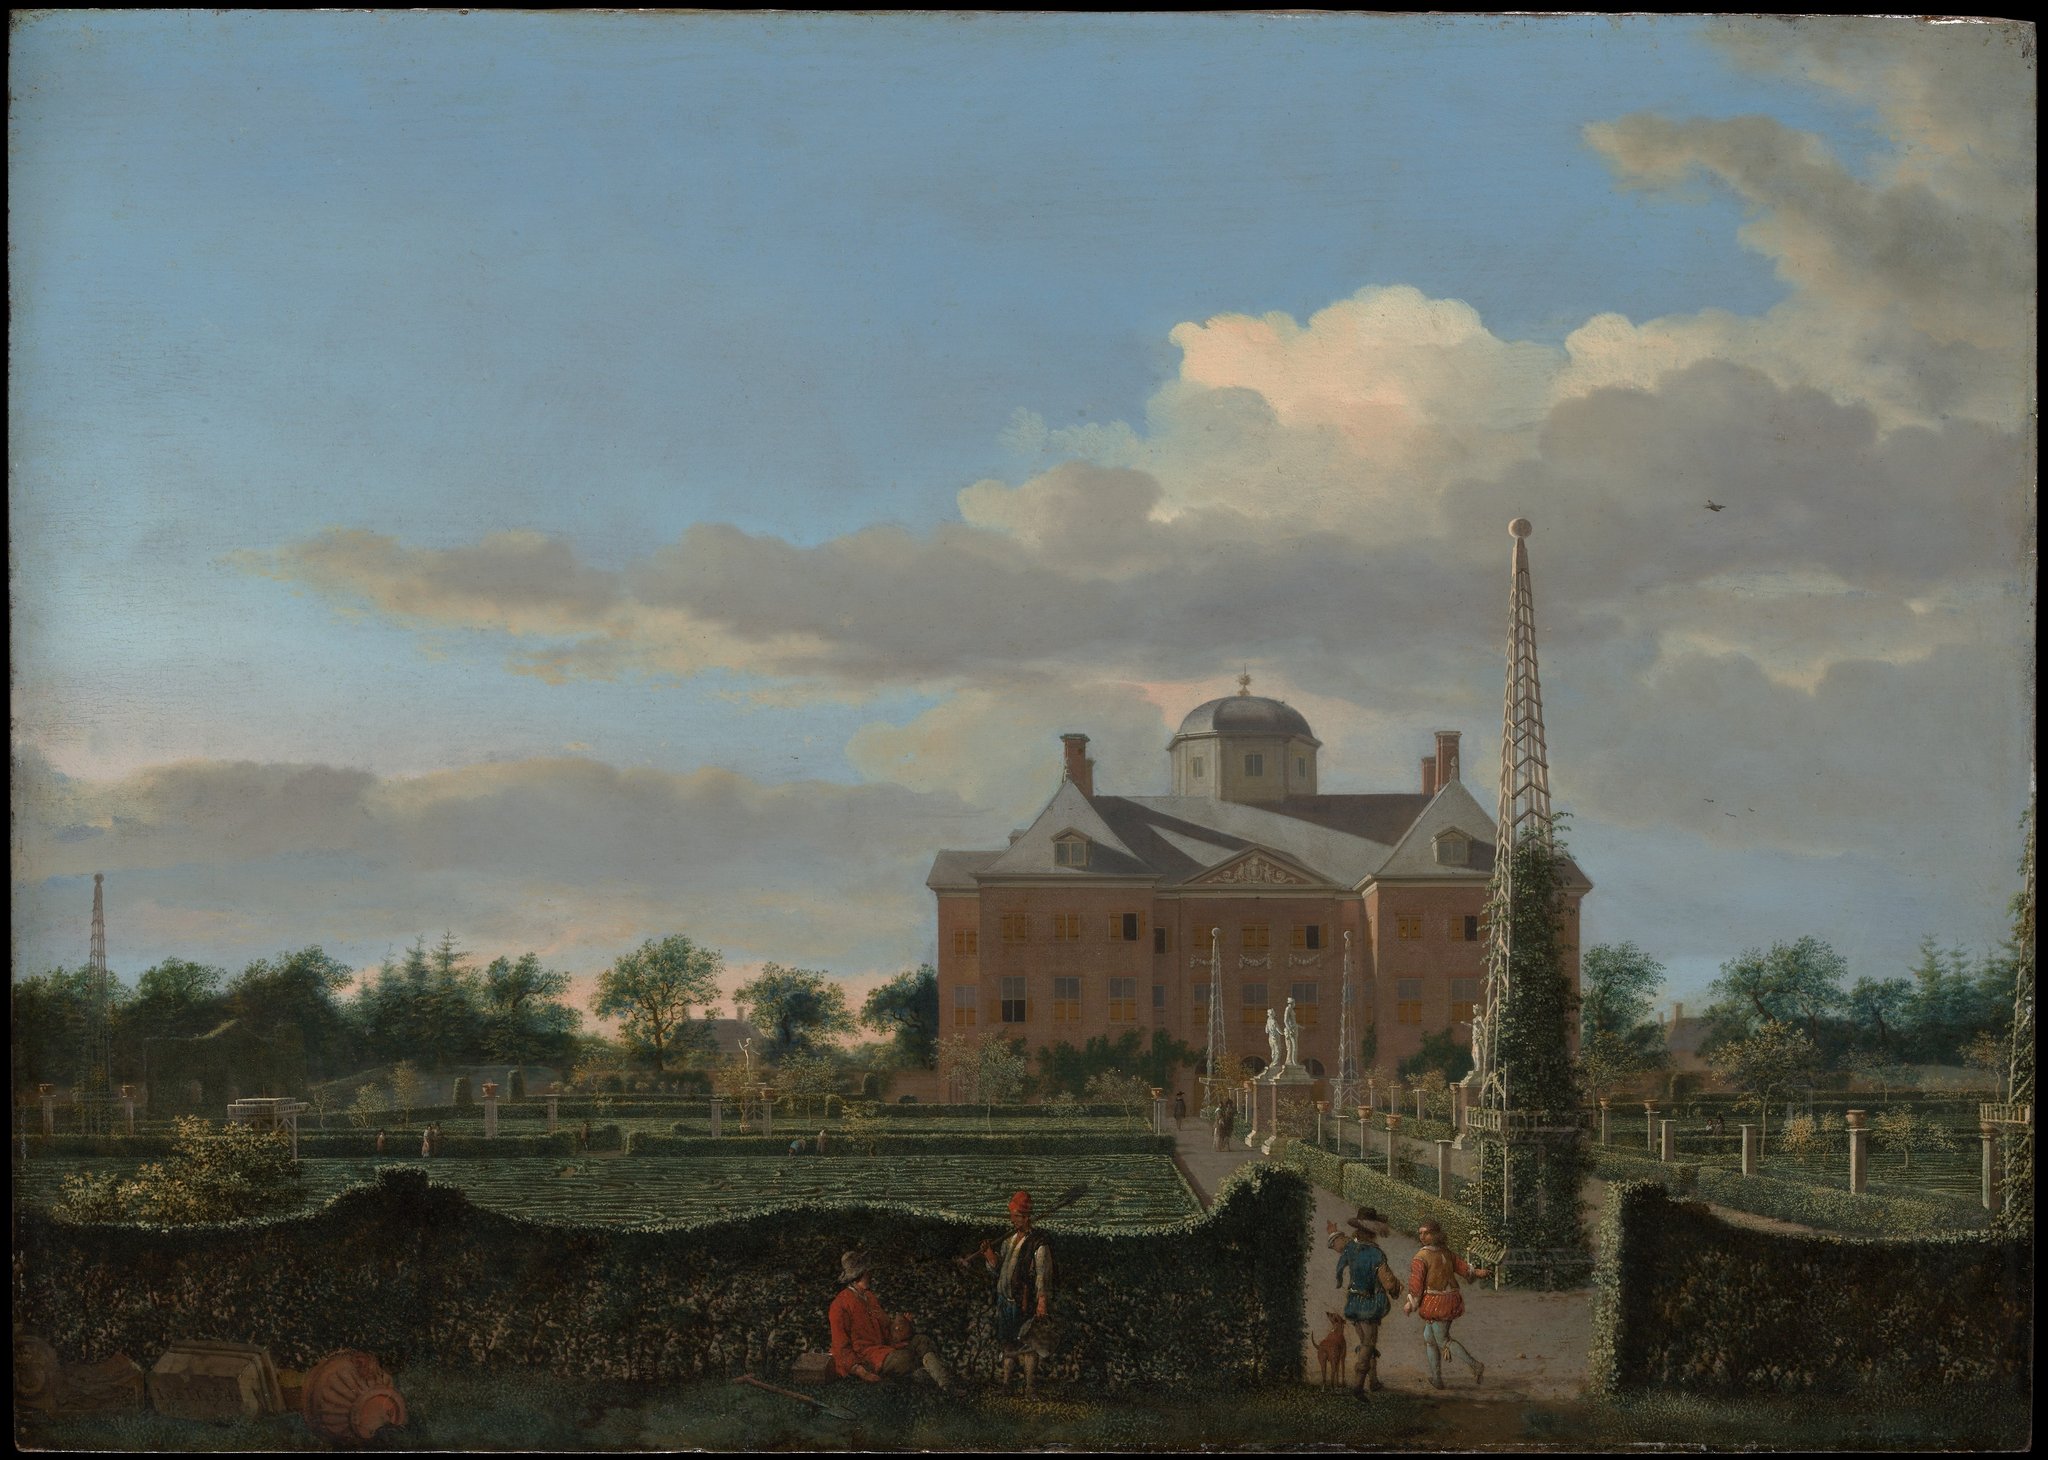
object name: painting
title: The Huis ten Bosch at The Hague and Its Formal Garden (View from the South)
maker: jan van der heyden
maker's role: artist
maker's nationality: dutch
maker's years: 1637-1712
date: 1668-1670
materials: oil, wood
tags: houses,gardens